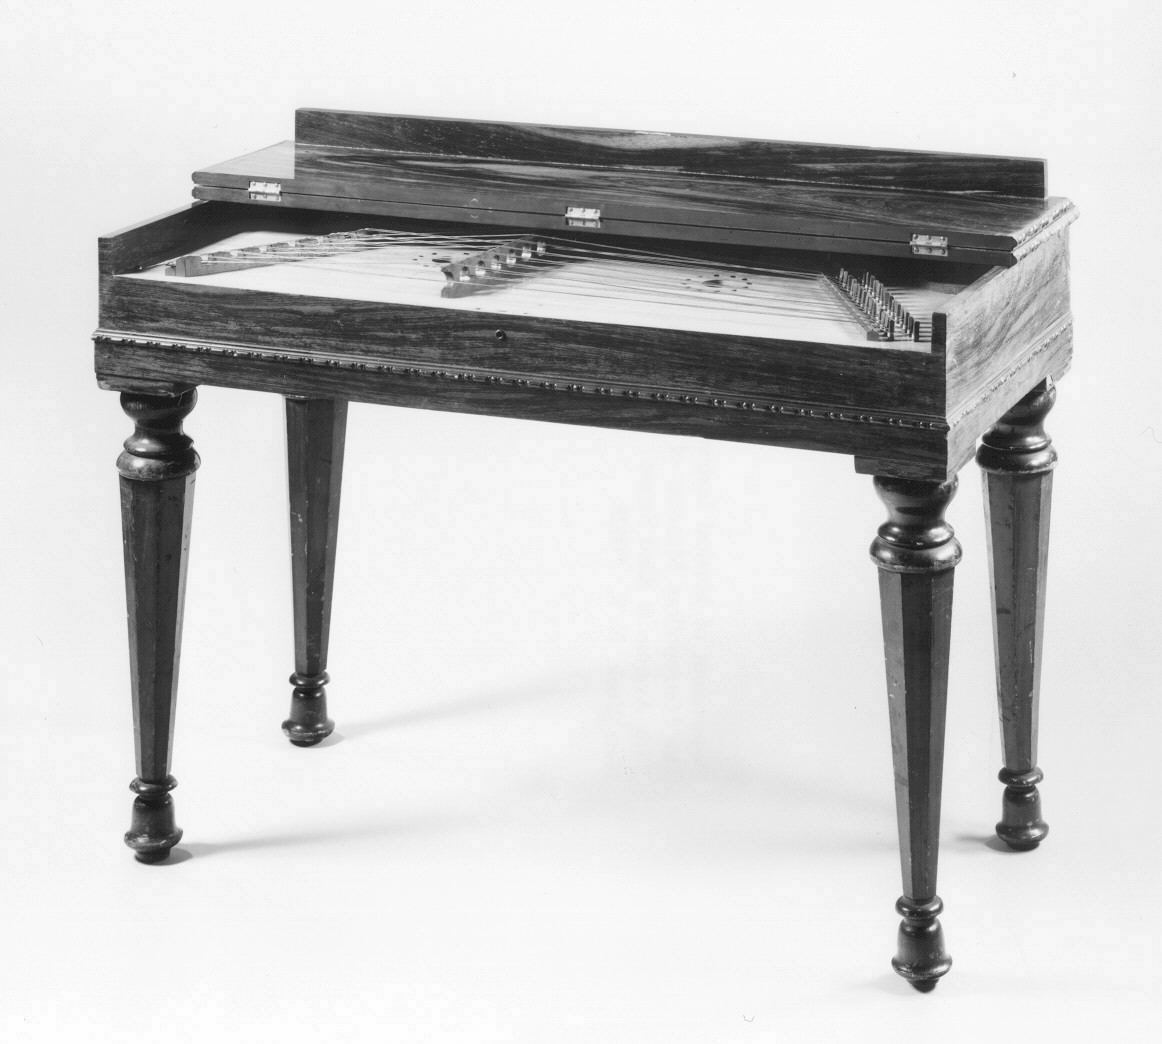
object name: hammer dulcimer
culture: american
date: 1870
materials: wood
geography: united states